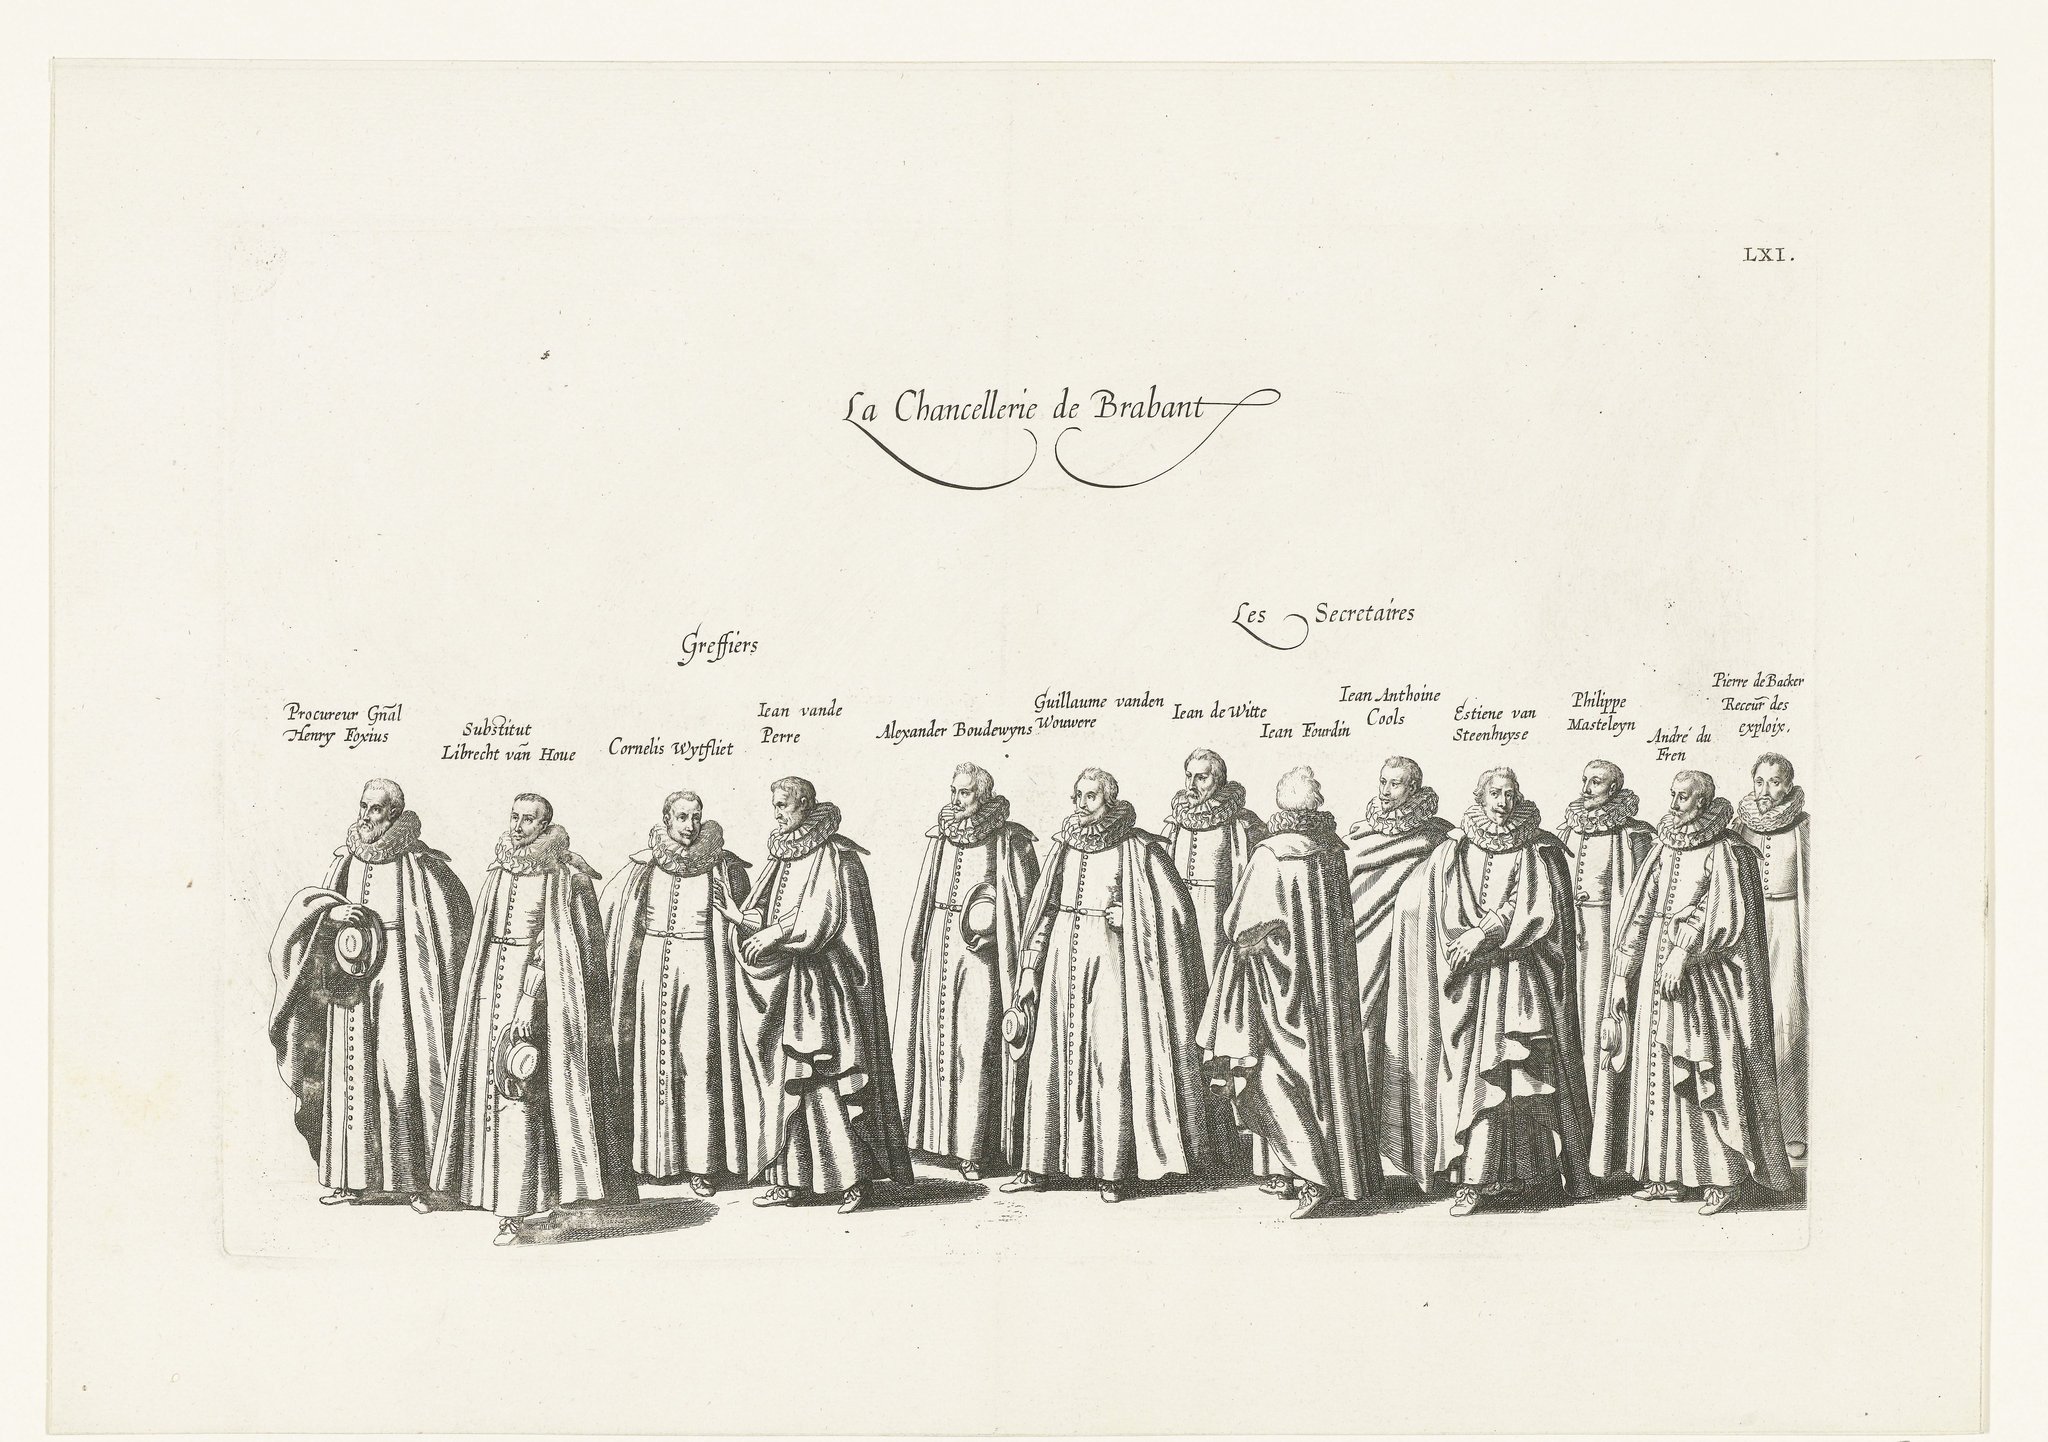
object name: print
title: Begrafenisstoet van aartshertog Albrecht (plaat LXI), 1622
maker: cornelis galle (i)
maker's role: print maker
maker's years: 1576-1650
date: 1623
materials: paper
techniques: etching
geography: southern netherlands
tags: brussels, albrecht aartshertog van oostenrijk, cortege, funeral procession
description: Deelnemers in de begrafenisstoet. Plaat LXI in de serie van de begrafenis van aartshertog Albrecht van Oostenrijk te Brussel op 12 maart 1622.